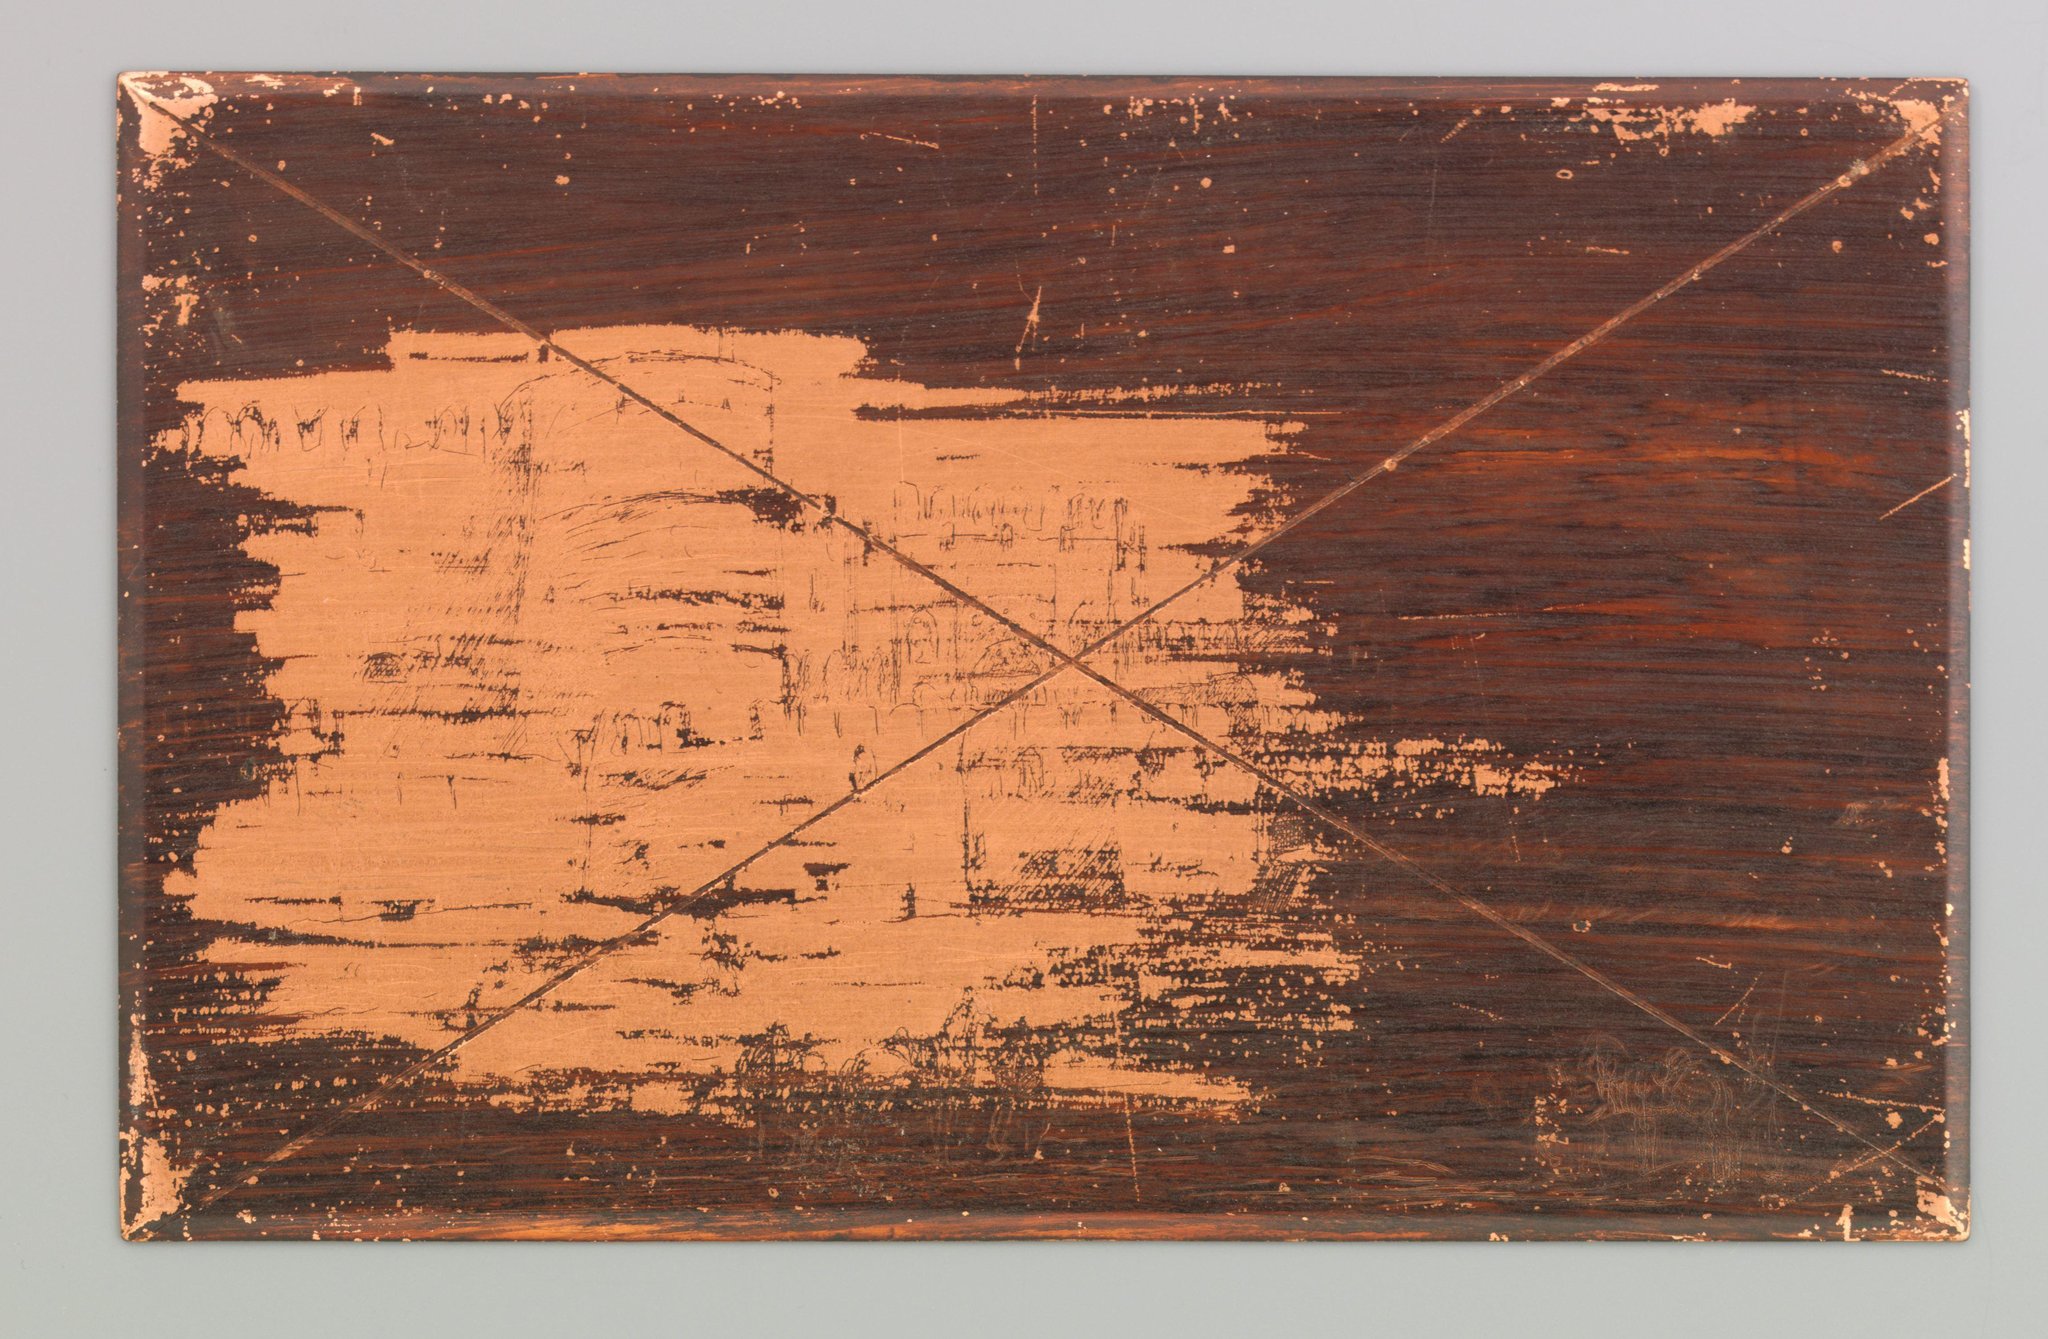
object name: copper plate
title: Fort te Agra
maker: marius bauer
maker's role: draughtsman, print maker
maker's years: 1867-1932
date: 1924-1932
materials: copper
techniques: etching